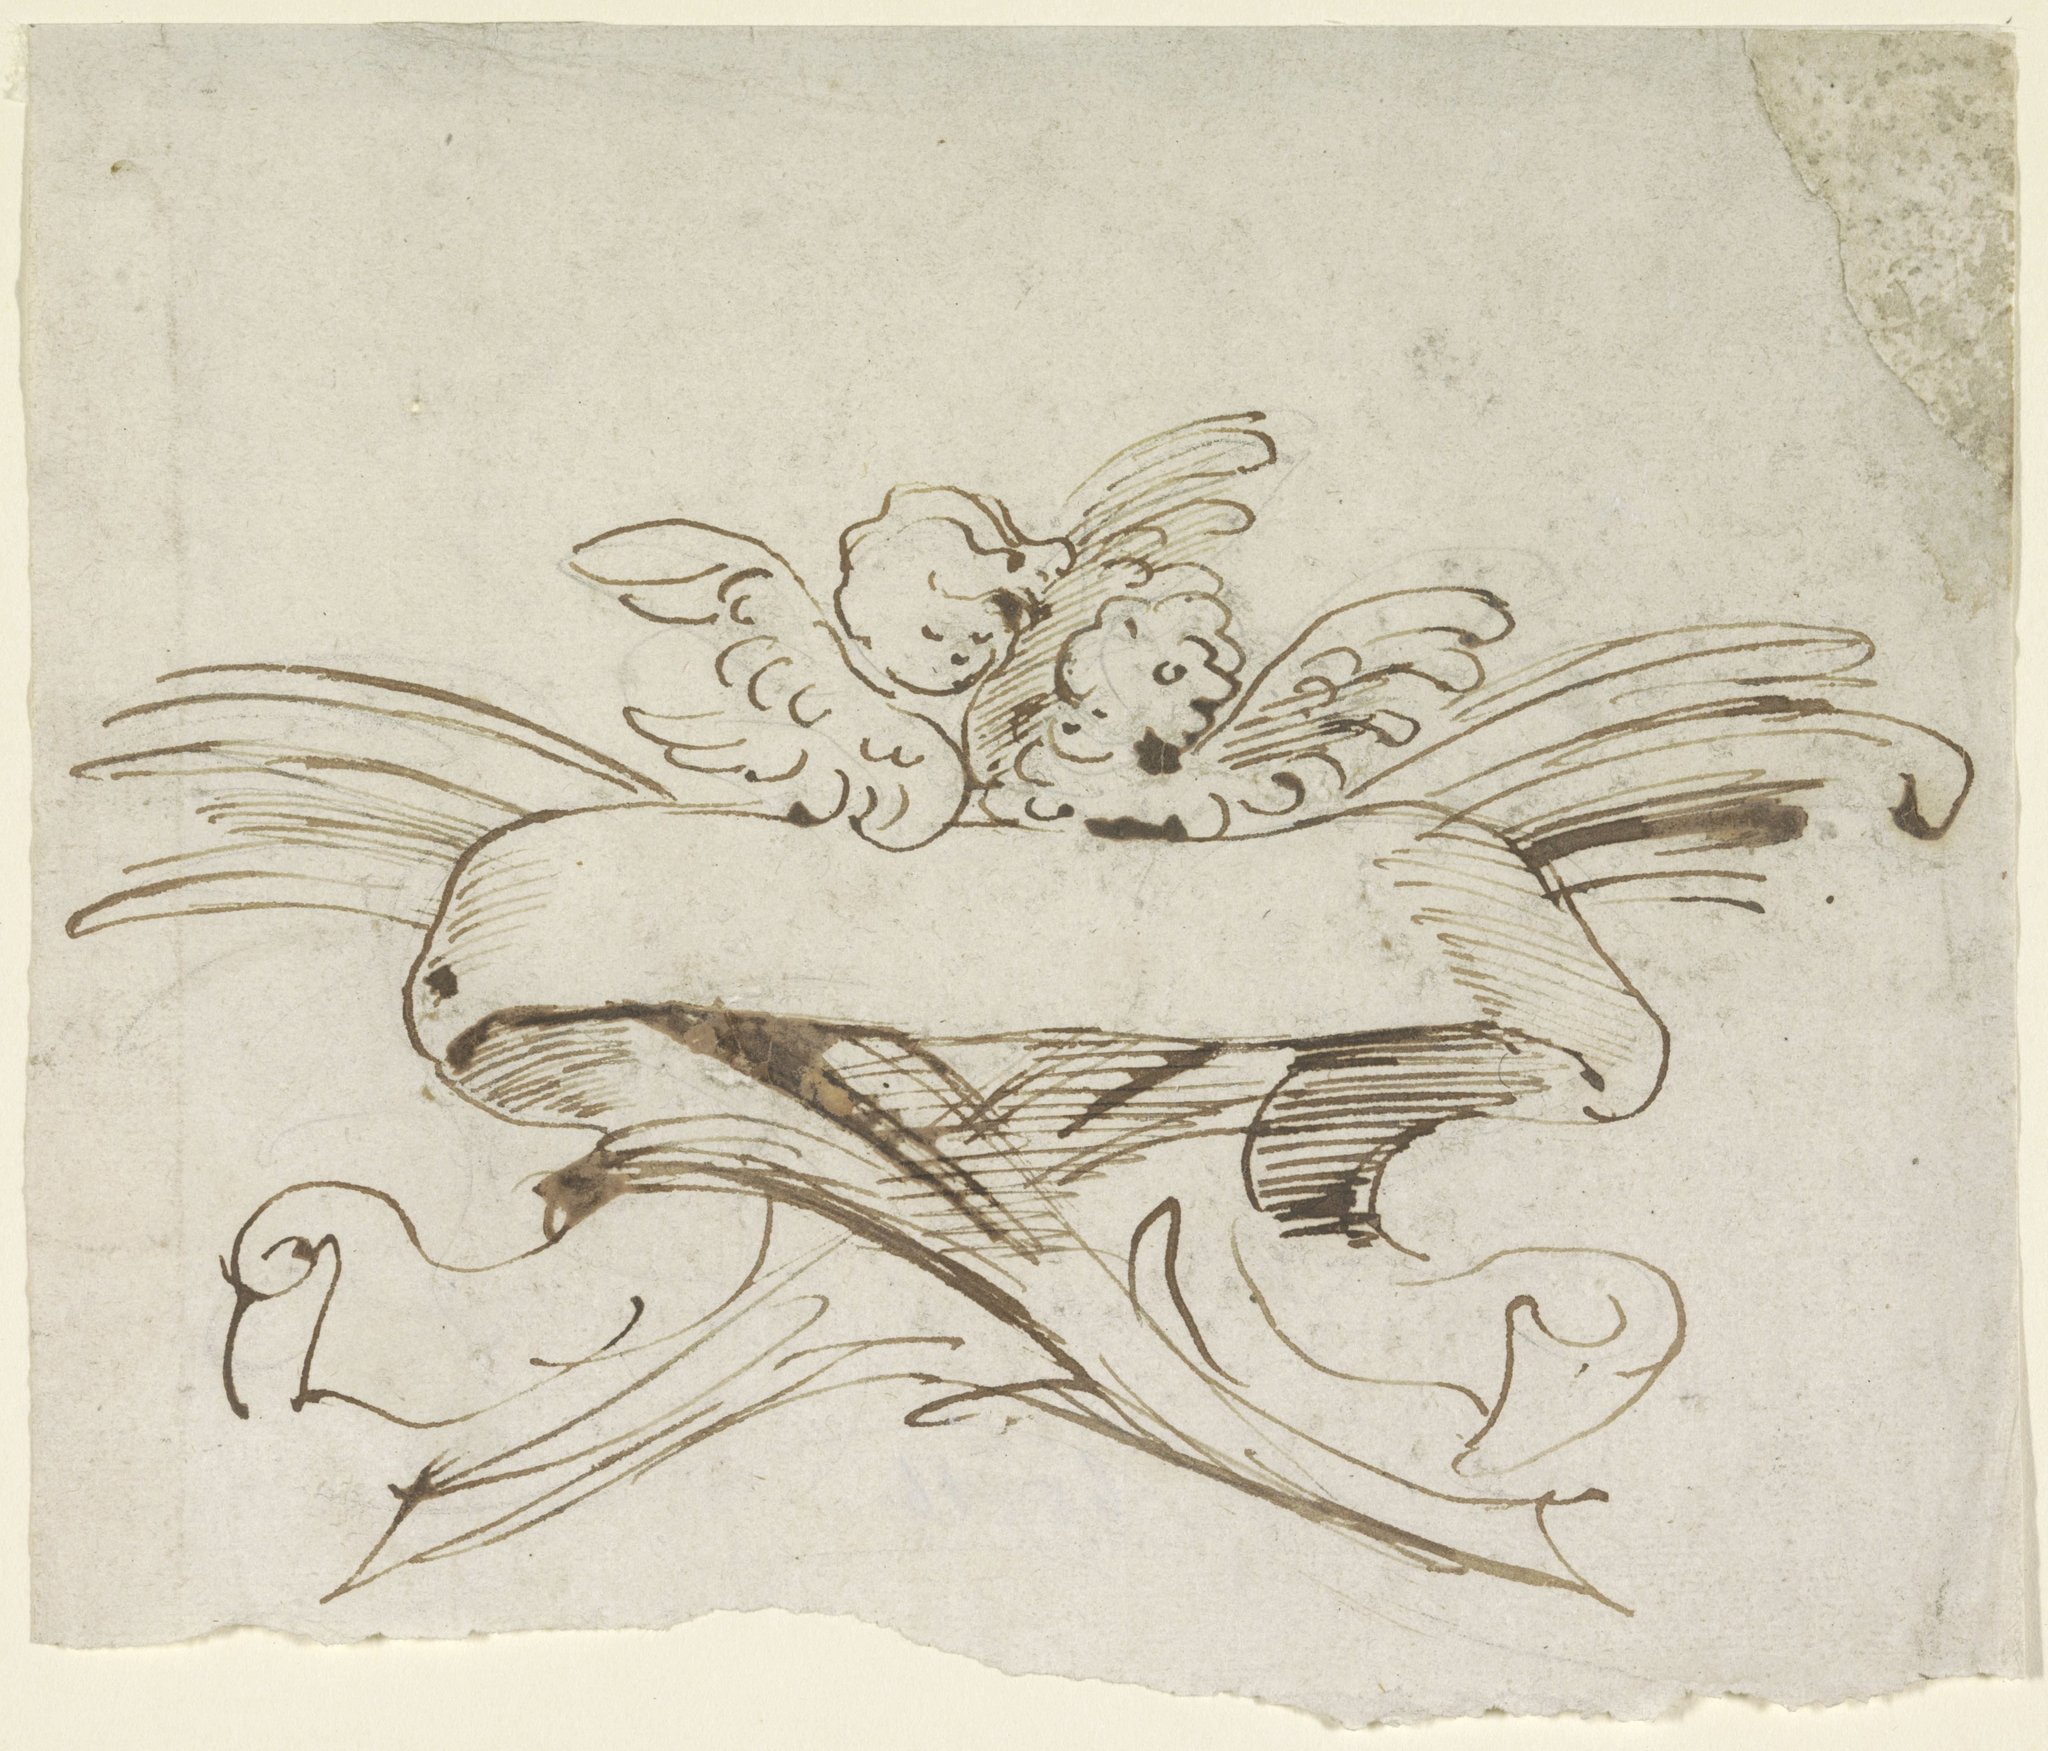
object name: ornamenttekening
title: Banderol met cherubijnen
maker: Anonymous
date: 1600-1800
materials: ink, paper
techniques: pen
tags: cherubs, i.e. children's heads with wings, ribbon, scroll, banderole ~ ornament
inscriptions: collector's mark: Lugt 2228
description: Een banderol met palmtakken en twee cherubijnen.